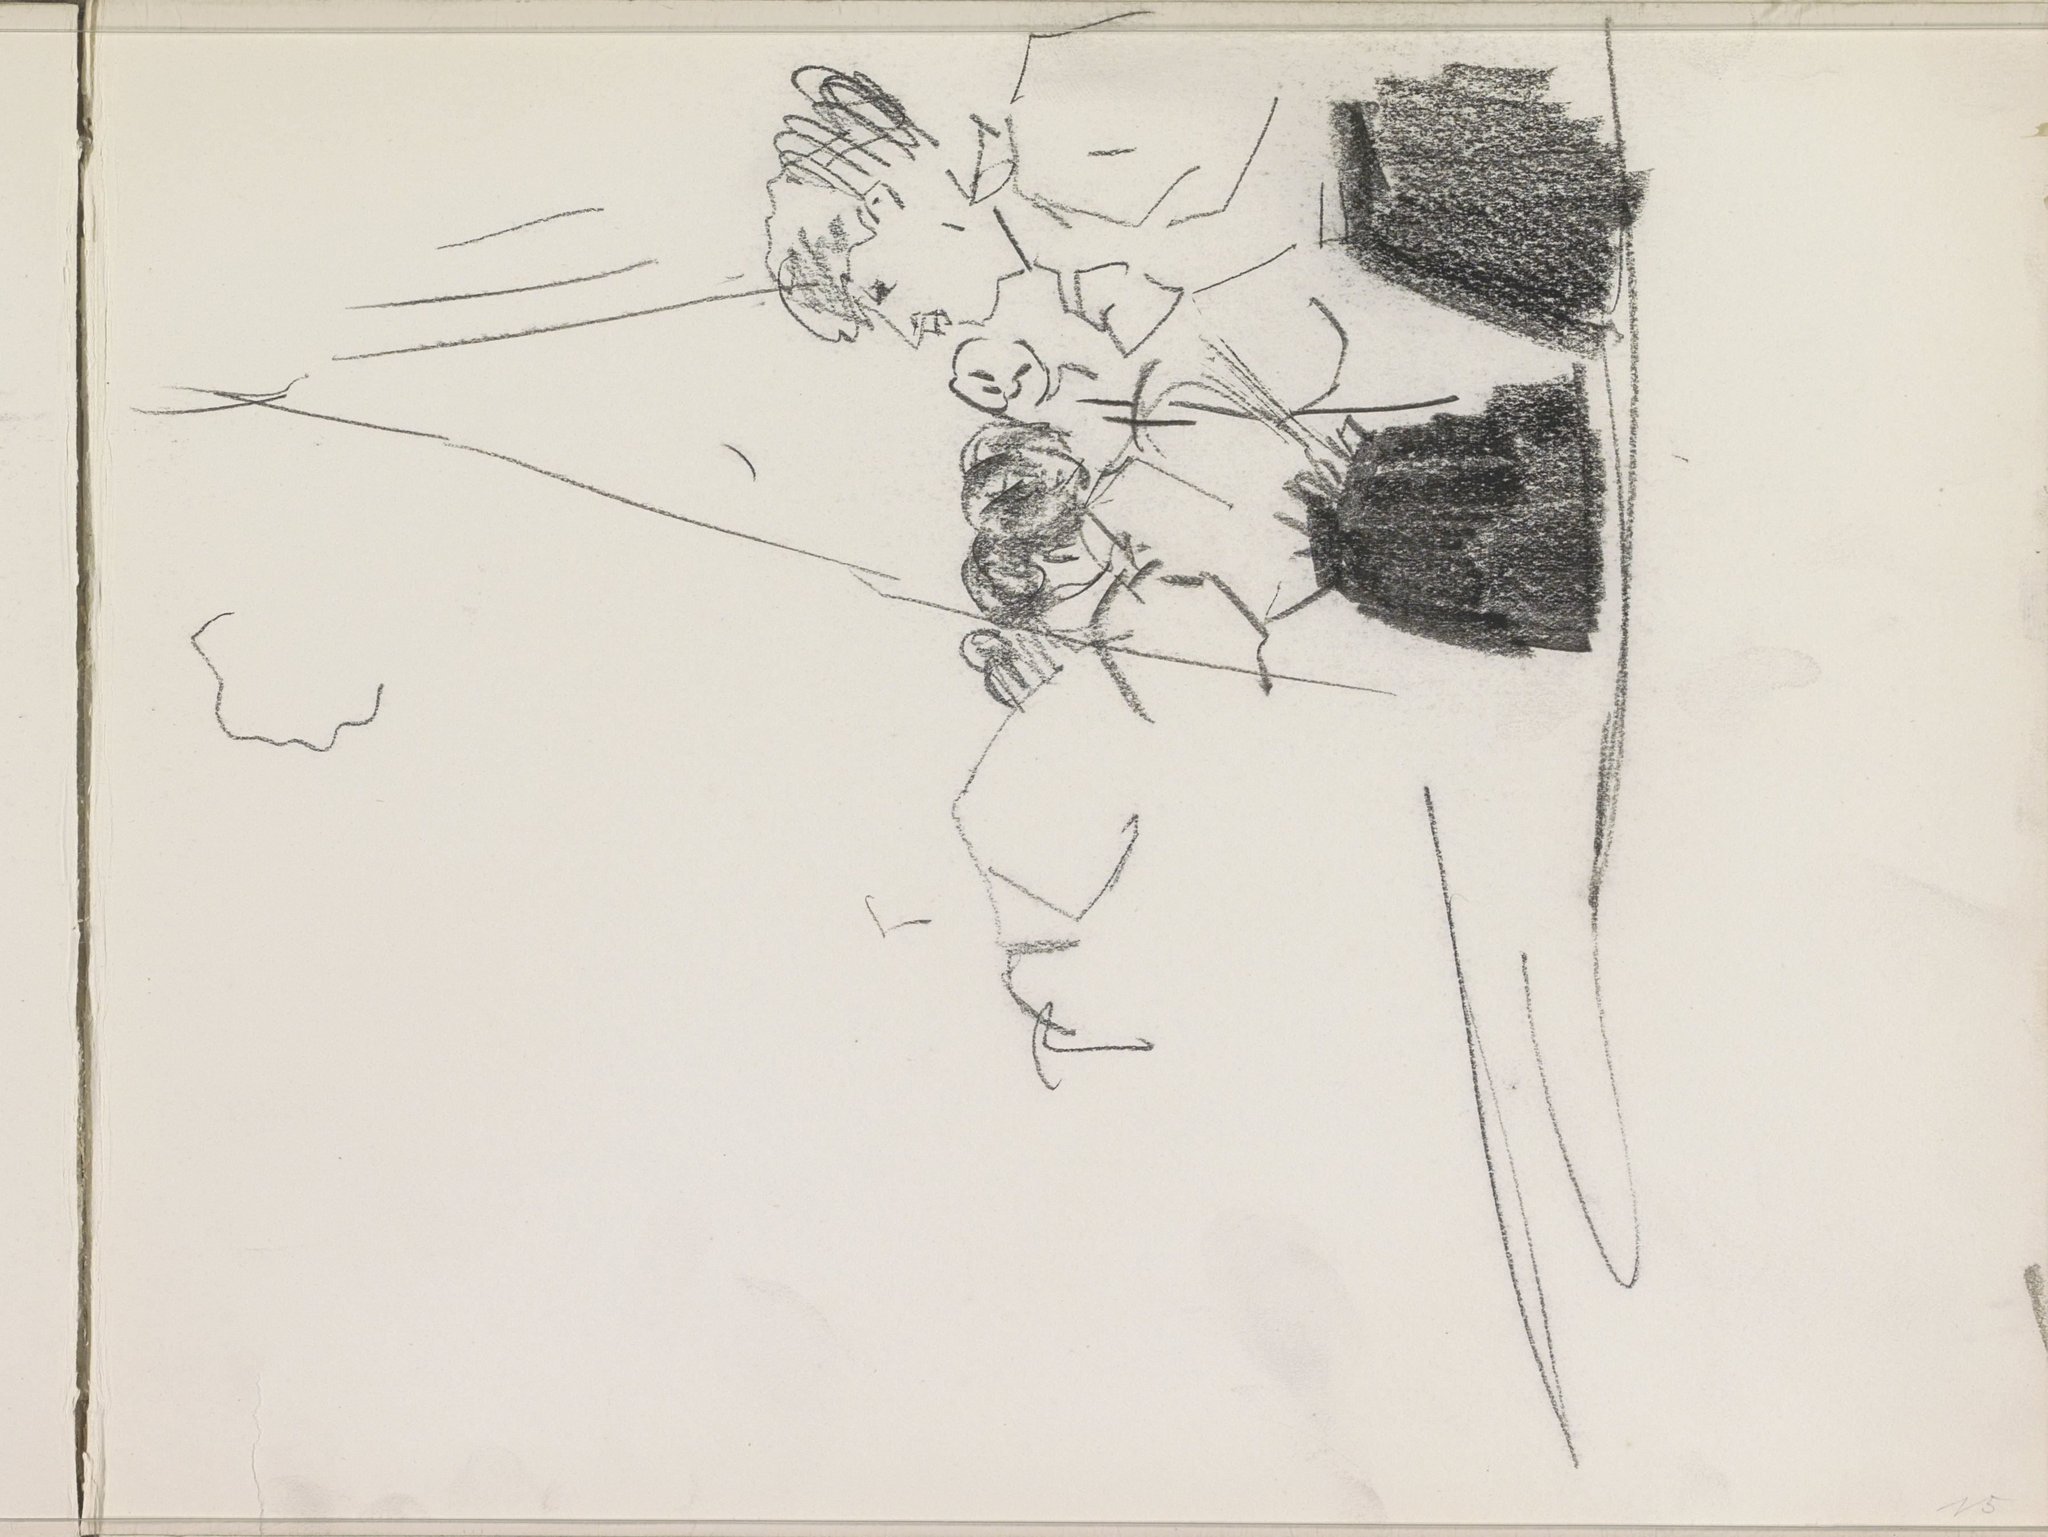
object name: sketchbook leaf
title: Studieblad met vrouwen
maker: isaac israels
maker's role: draughtsman, painter, print maker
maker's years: 1865-1934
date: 1875-1934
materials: chalk, paper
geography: the hague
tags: adult woman (+ two persons)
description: Blad 15 recto uit schetsboek VII met 26 bladen.